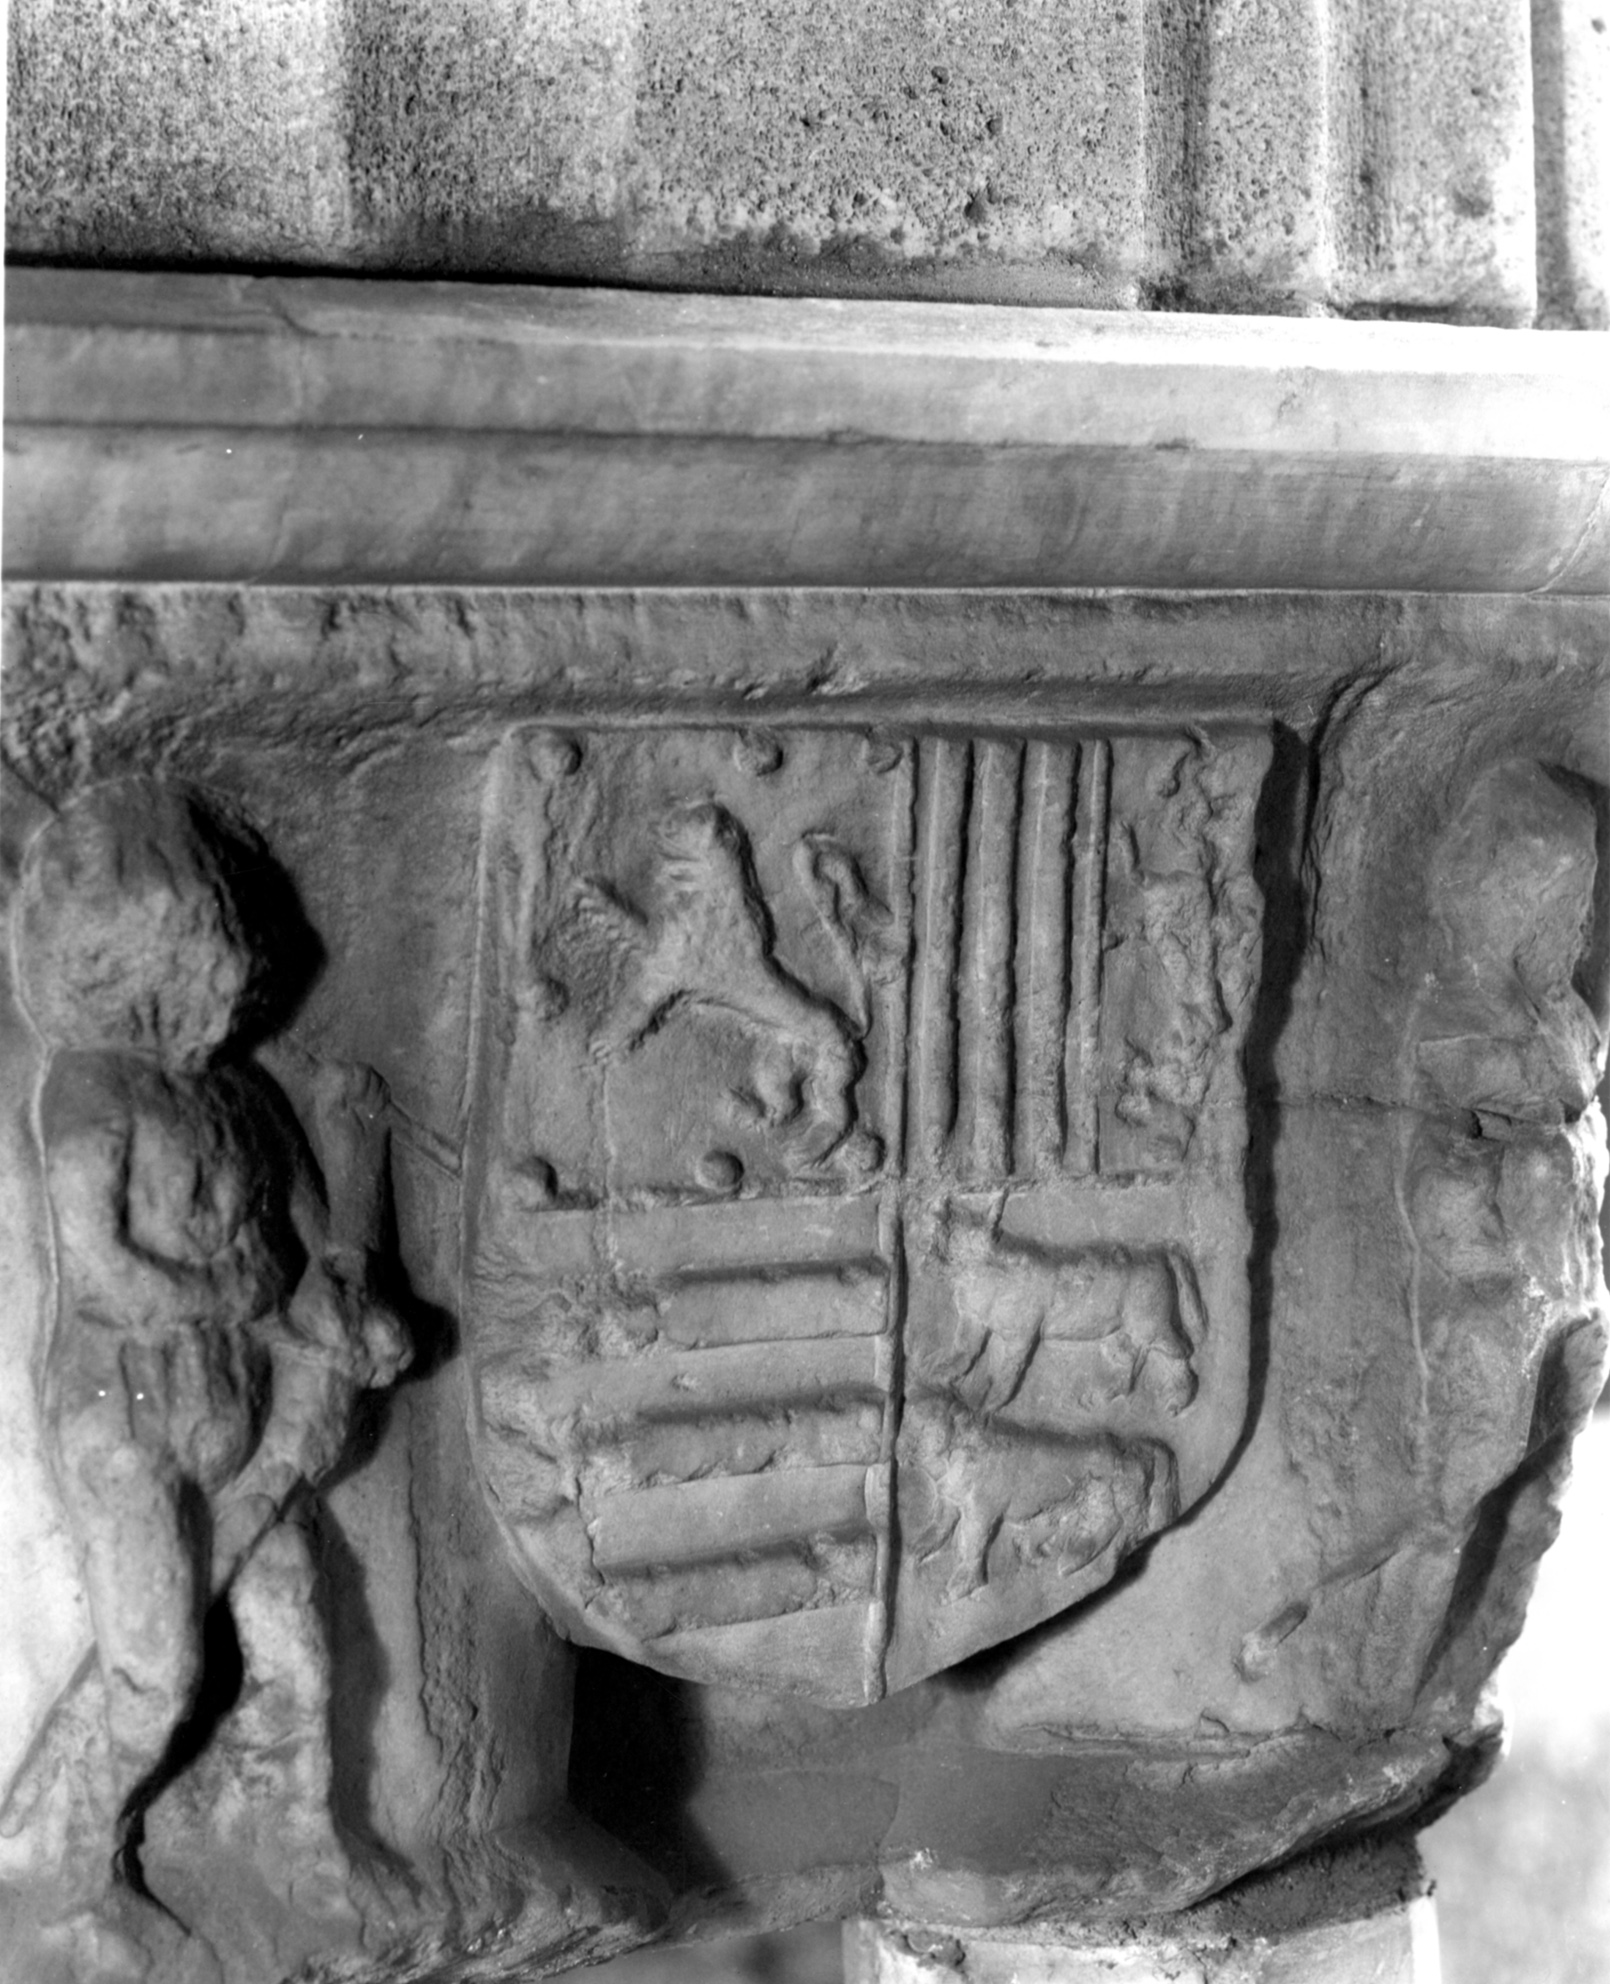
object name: capital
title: Double Capital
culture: french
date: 1467-1500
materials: marble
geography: france